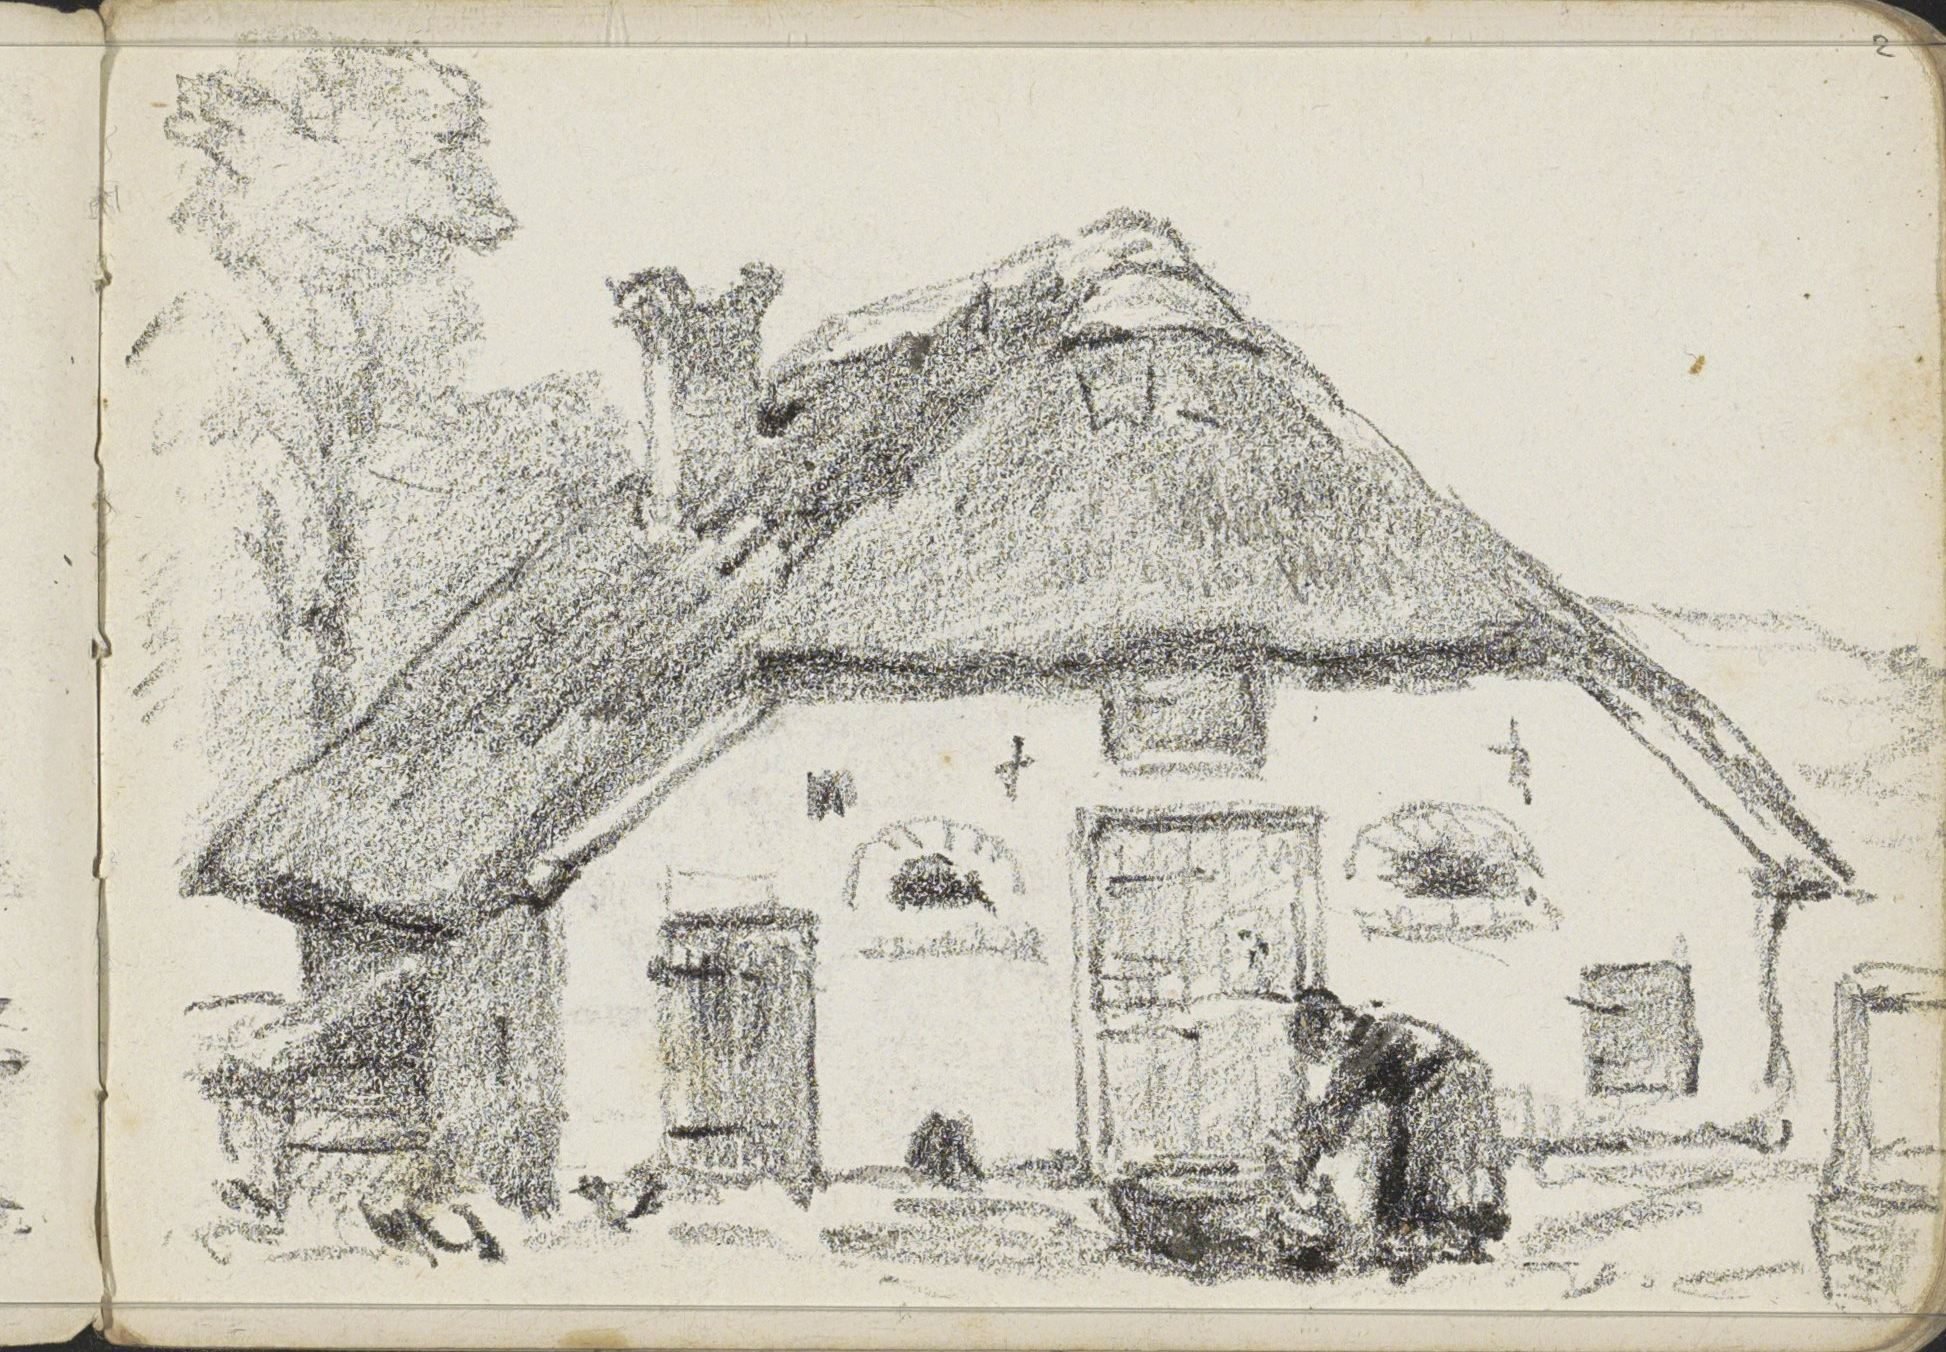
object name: sketchbook leaf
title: Werkende vrouw voor een boerderij te Dennenheuvel bij Hattem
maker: willem cornelis rip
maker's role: draughtsman, painter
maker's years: 1856-1922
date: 1907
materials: chalk, paper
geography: hattem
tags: farmers - aa - female farmer, farmer's wife, farm (building)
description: Blad 2 recto uit een schetsboek met 41 bladen.